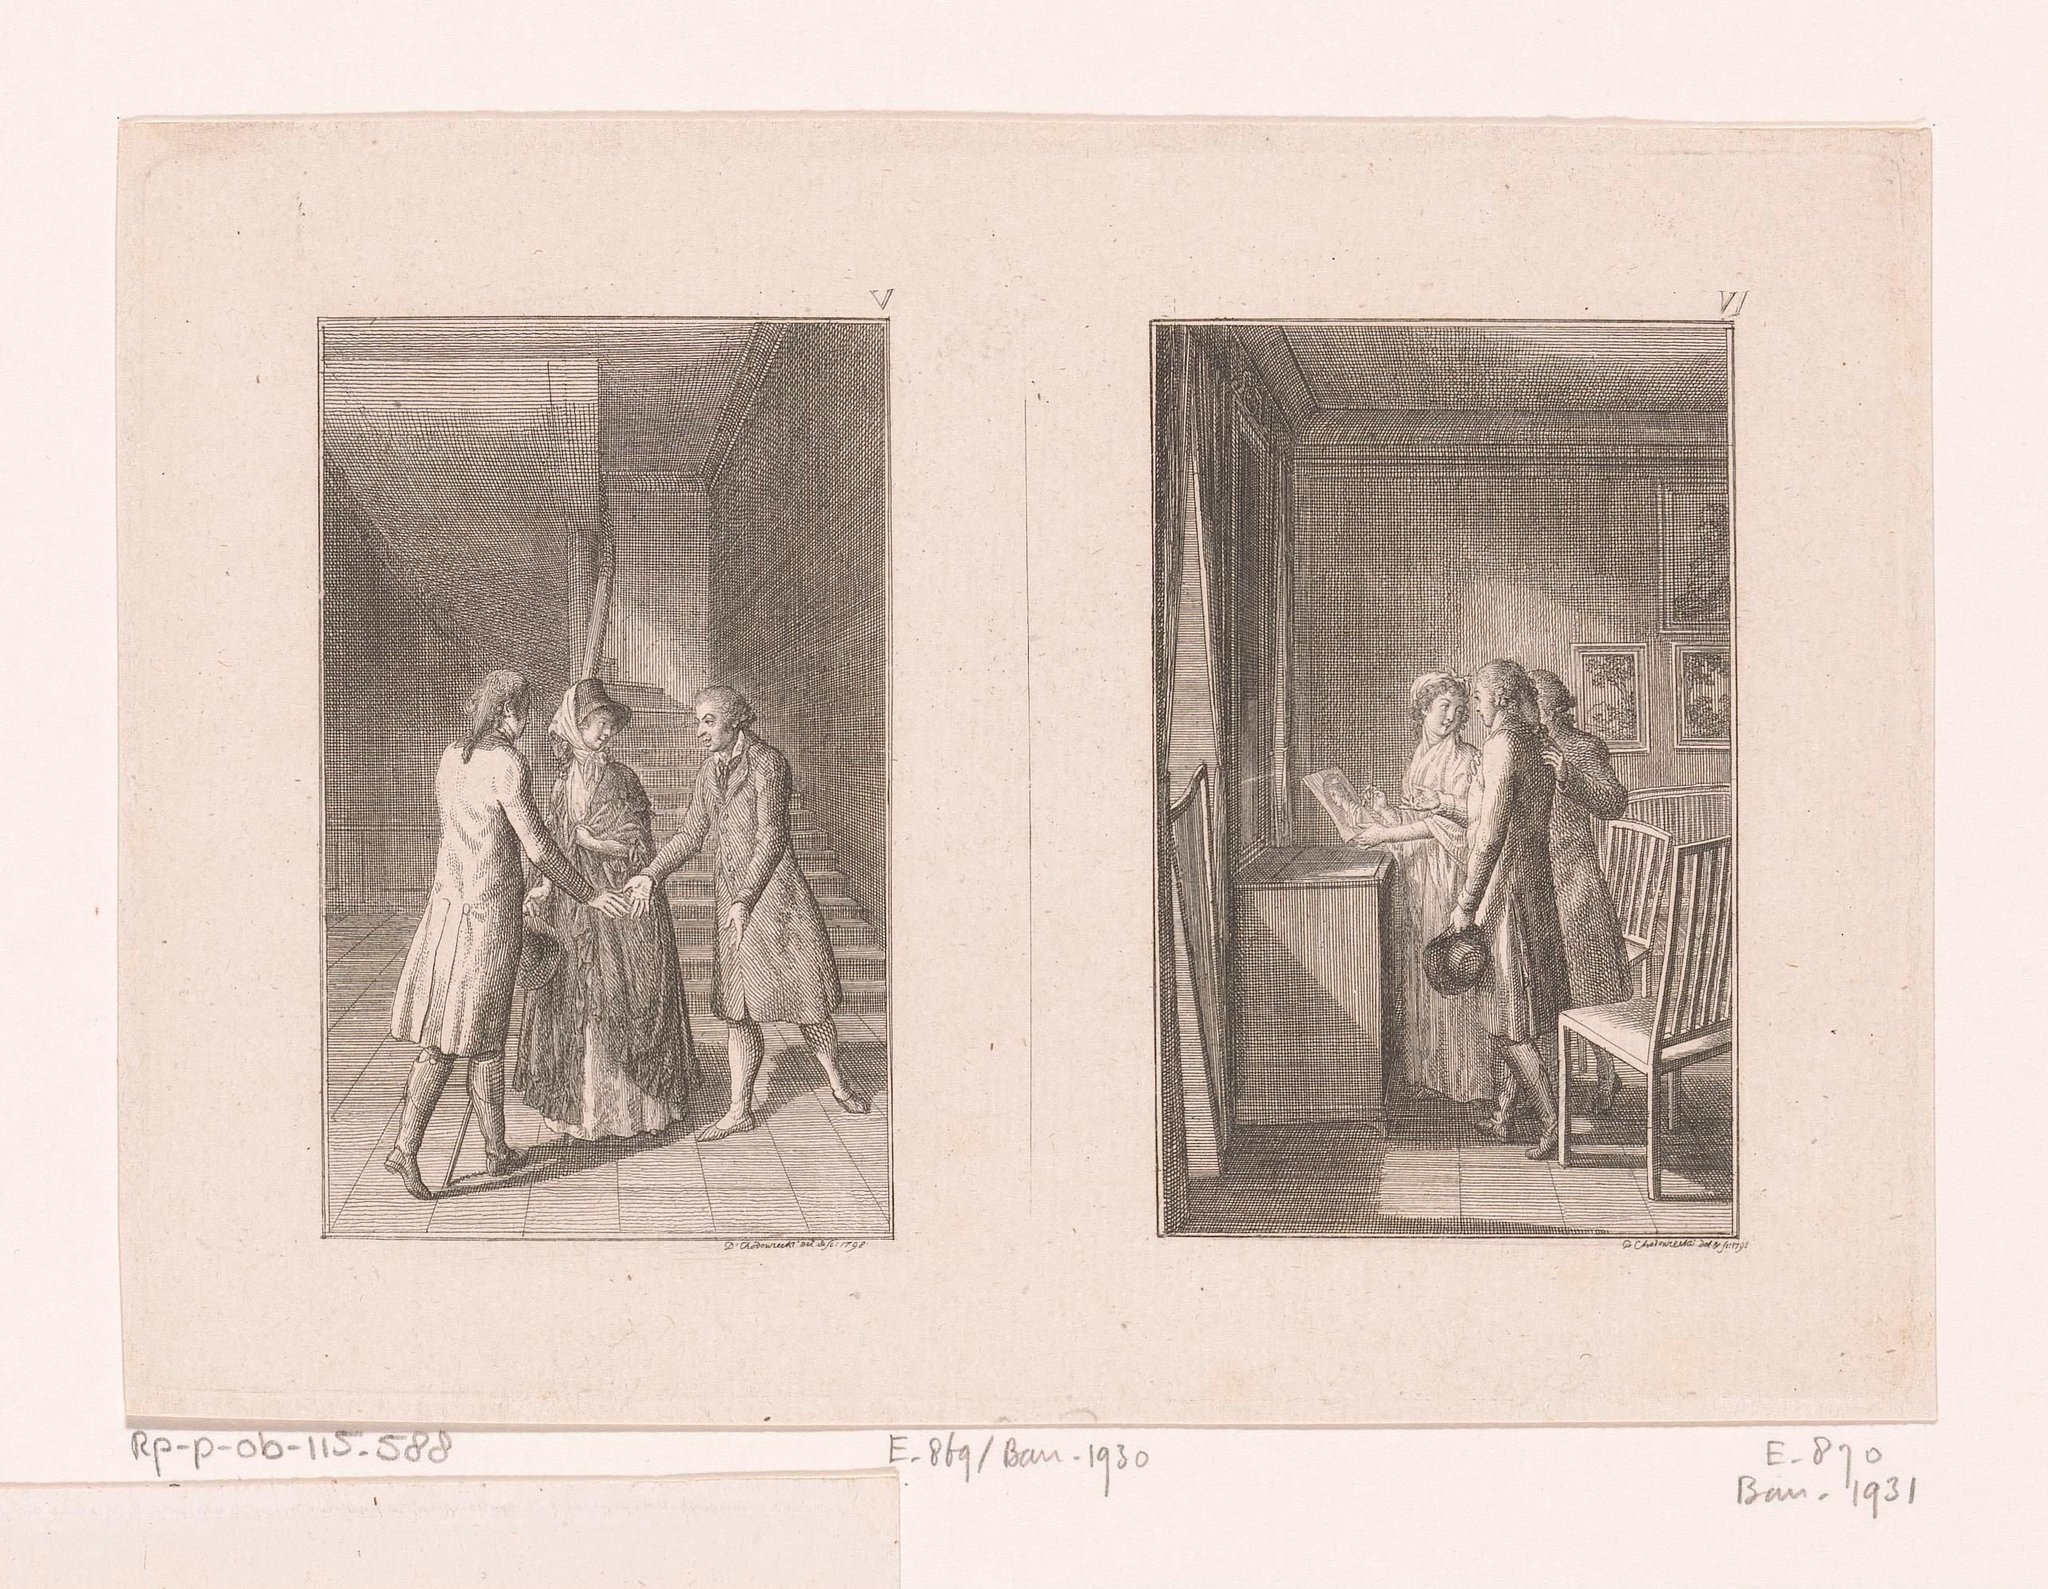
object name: print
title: Twee voorstellingen uit de verhalen van Wilhelm Gottlieb Becker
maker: daniel nikolaus chodowiecki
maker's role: draughtsman, print maker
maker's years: 1726-1801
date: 1798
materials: paper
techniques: etching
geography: berlin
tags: shaking hands, 'dextrarum junctio', staircase, portrait, self-portrait of artist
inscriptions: collector's mark: Lugt 2228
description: Prenten gebruikt voor: Becker, Wilhelm Gottlieb. Almanach und Taschenbuch zum geselligen Vergnügen von W. G. Becker für 1799. Leipzig: Voss und Comp., 1798.